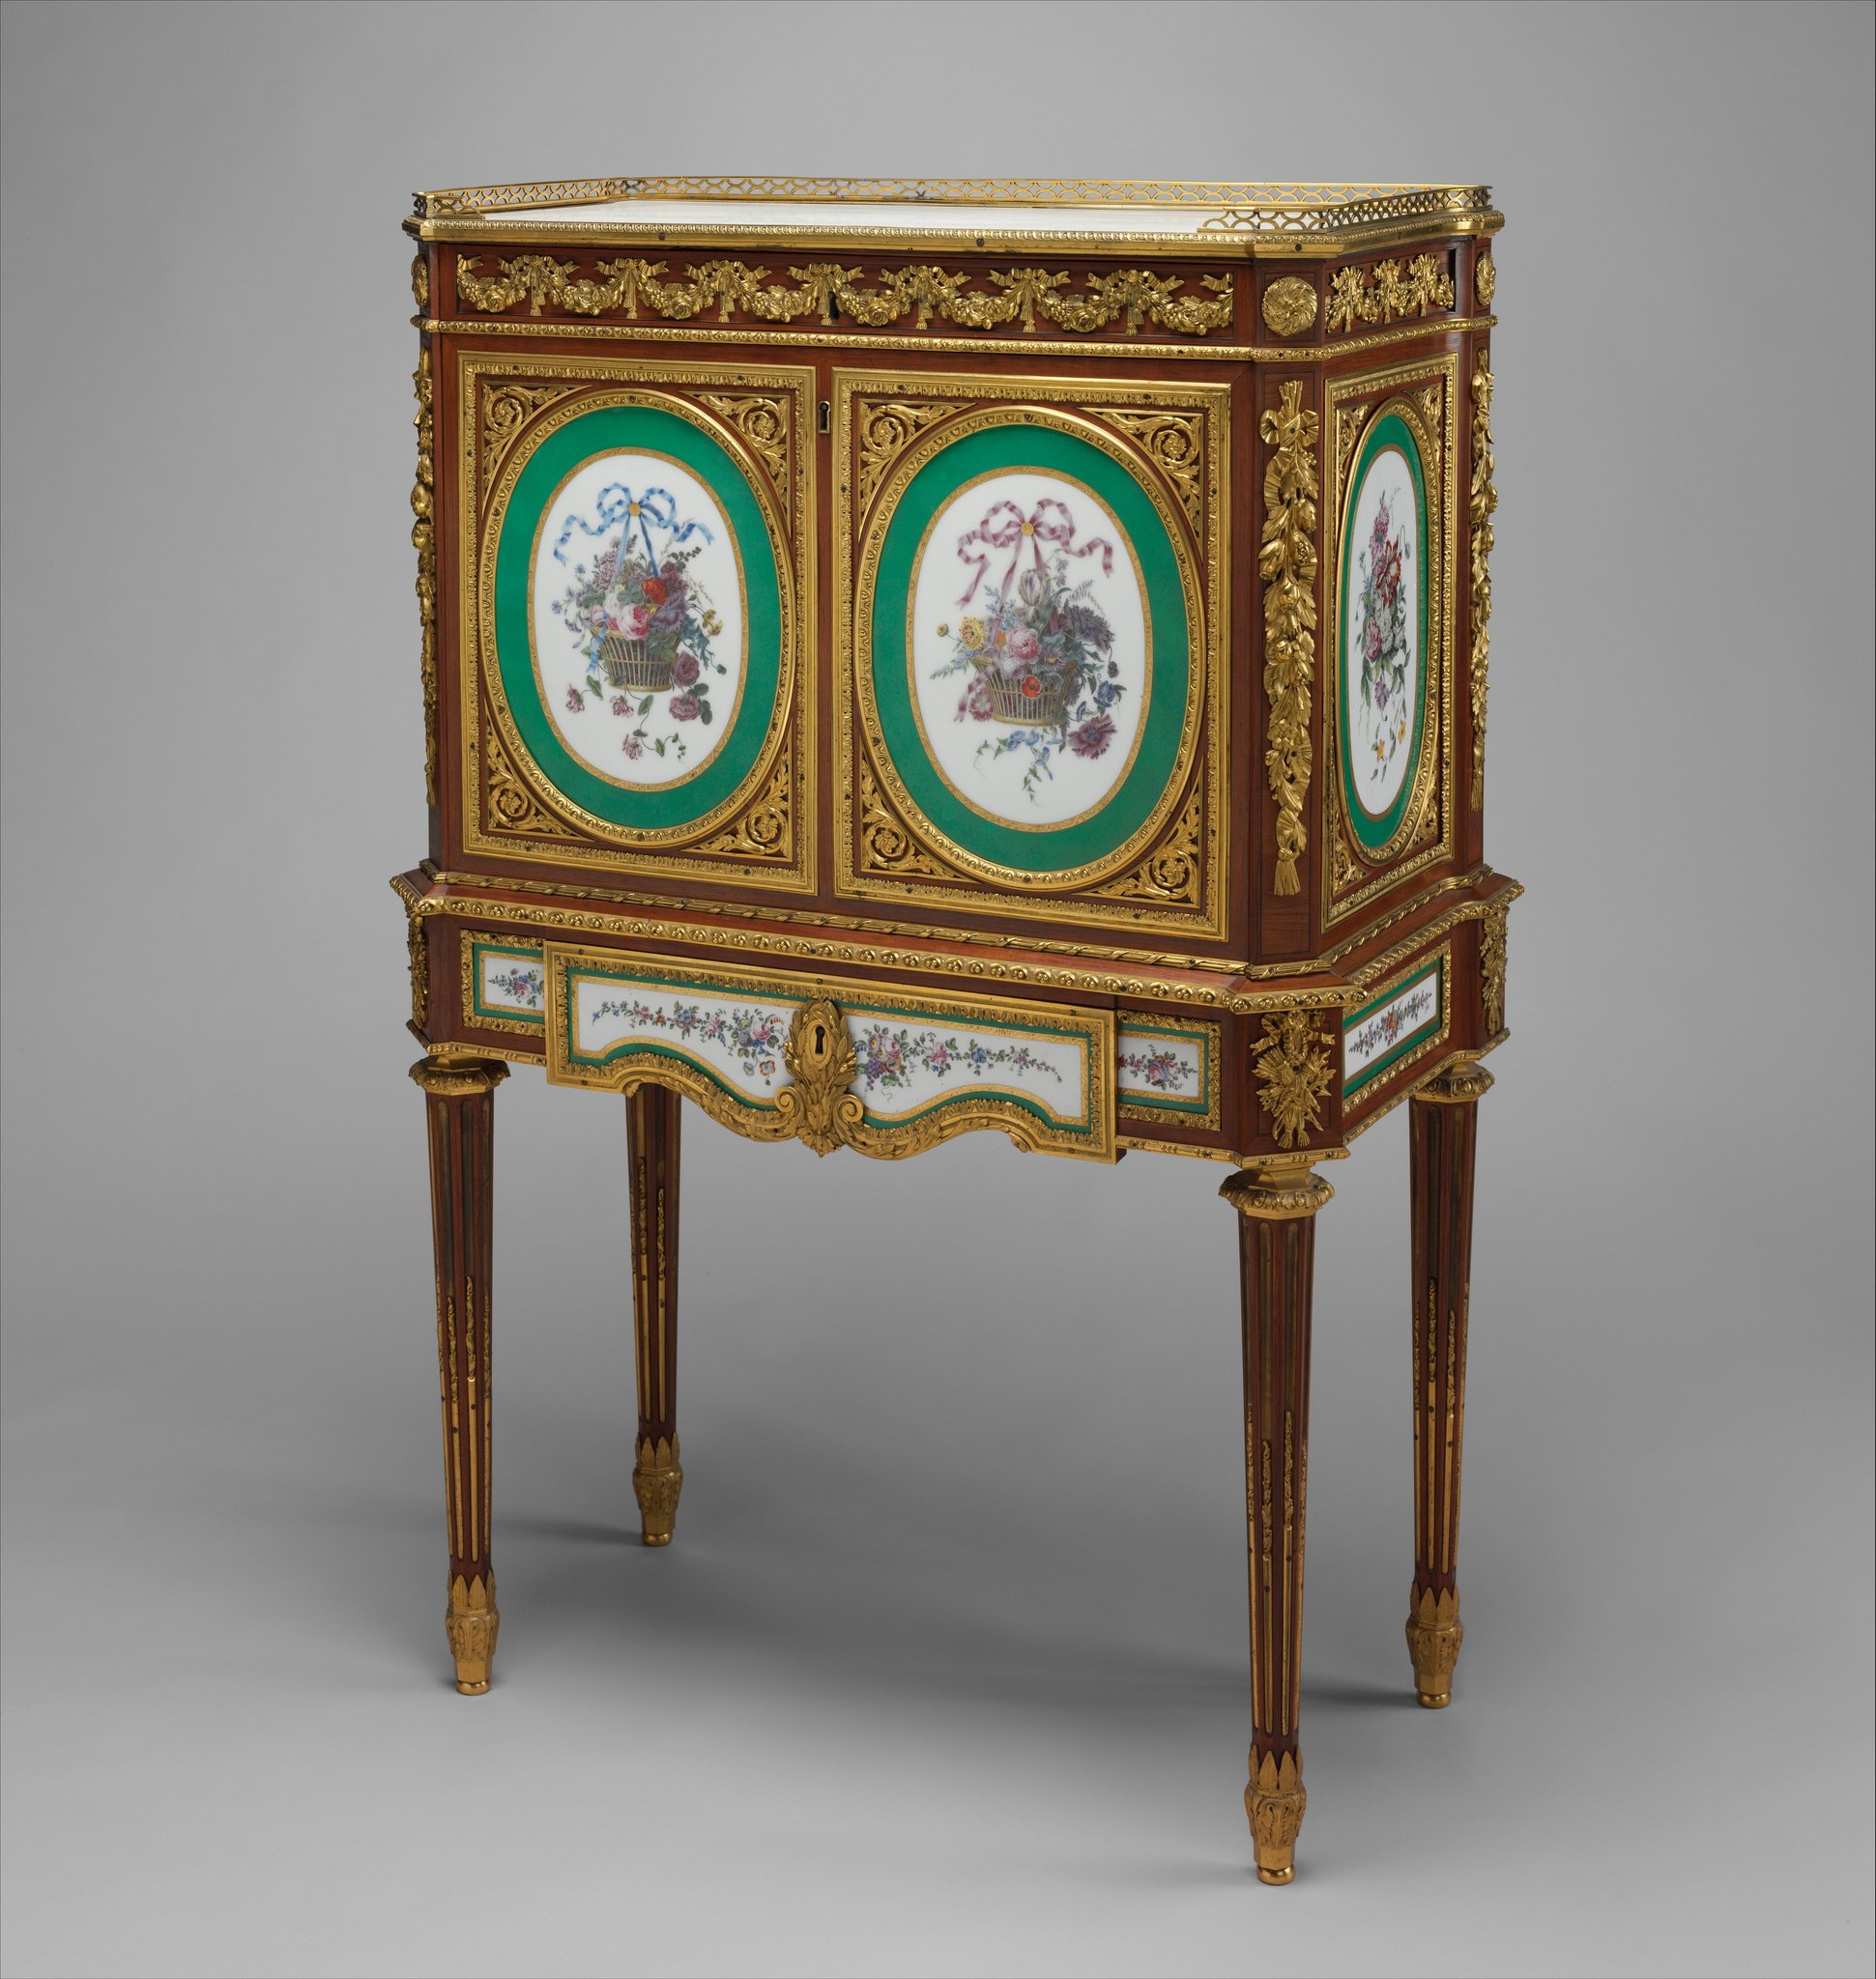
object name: desk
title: Drop-front desk (secrétaire à abattant or secrétaire en cabinet)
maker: martin carlin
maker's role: maker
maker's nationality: french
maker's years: 1725-1785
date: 1773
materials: gilt bronze, marble, wood, soft paste porcelain, velvet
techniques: veneering